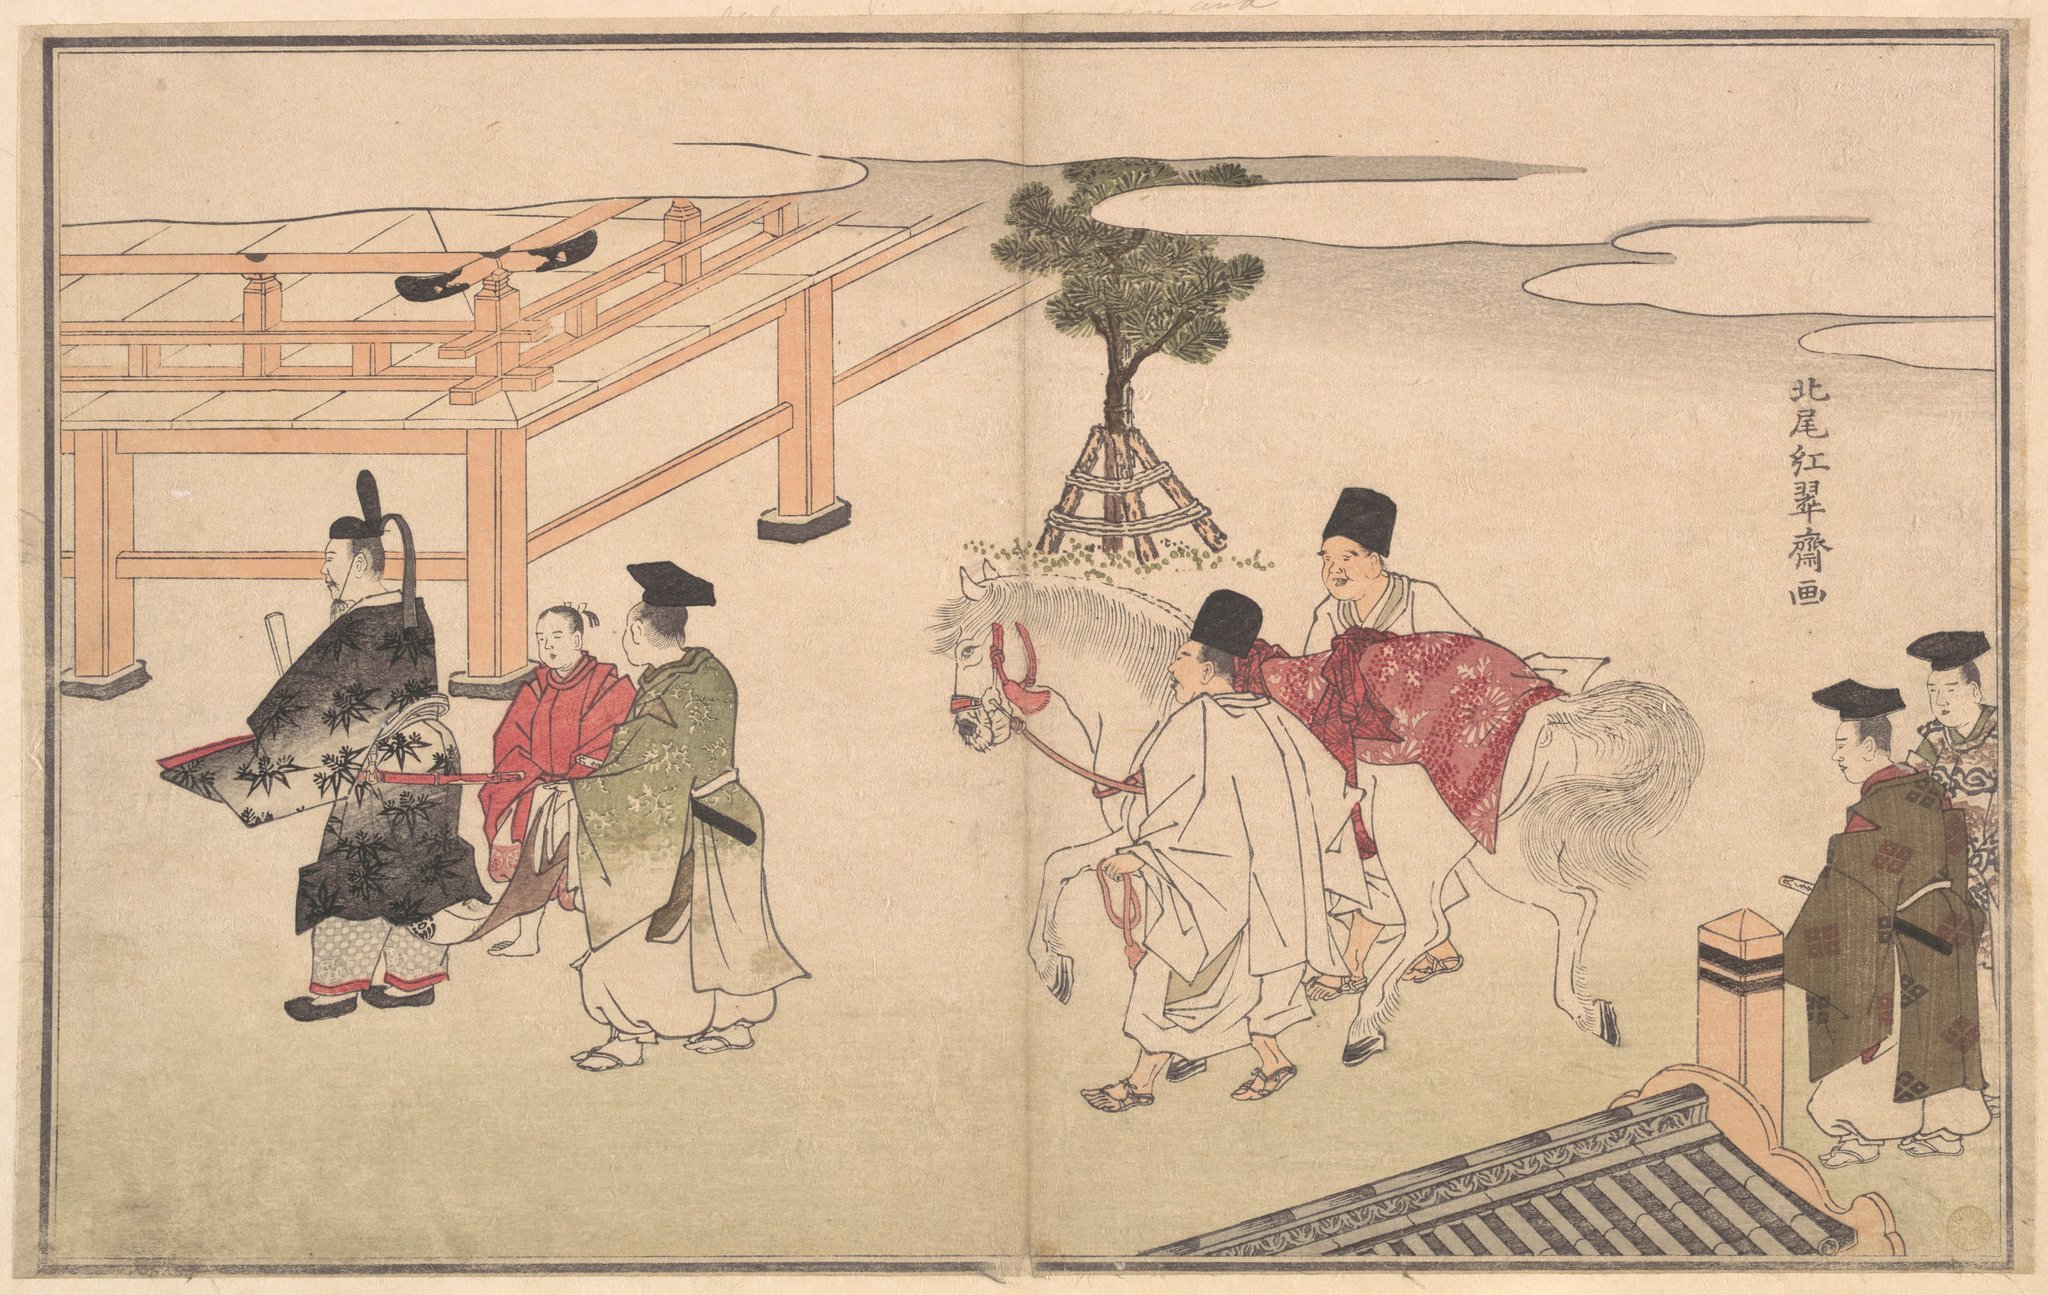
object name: print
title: Hakuba no Sechie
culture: japanese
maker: kitao shigemasa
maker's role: artist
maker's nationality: japanese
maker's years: 1739-1820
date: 1739-1820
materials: ink, paper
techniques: woodblock print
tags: men,horses,trees